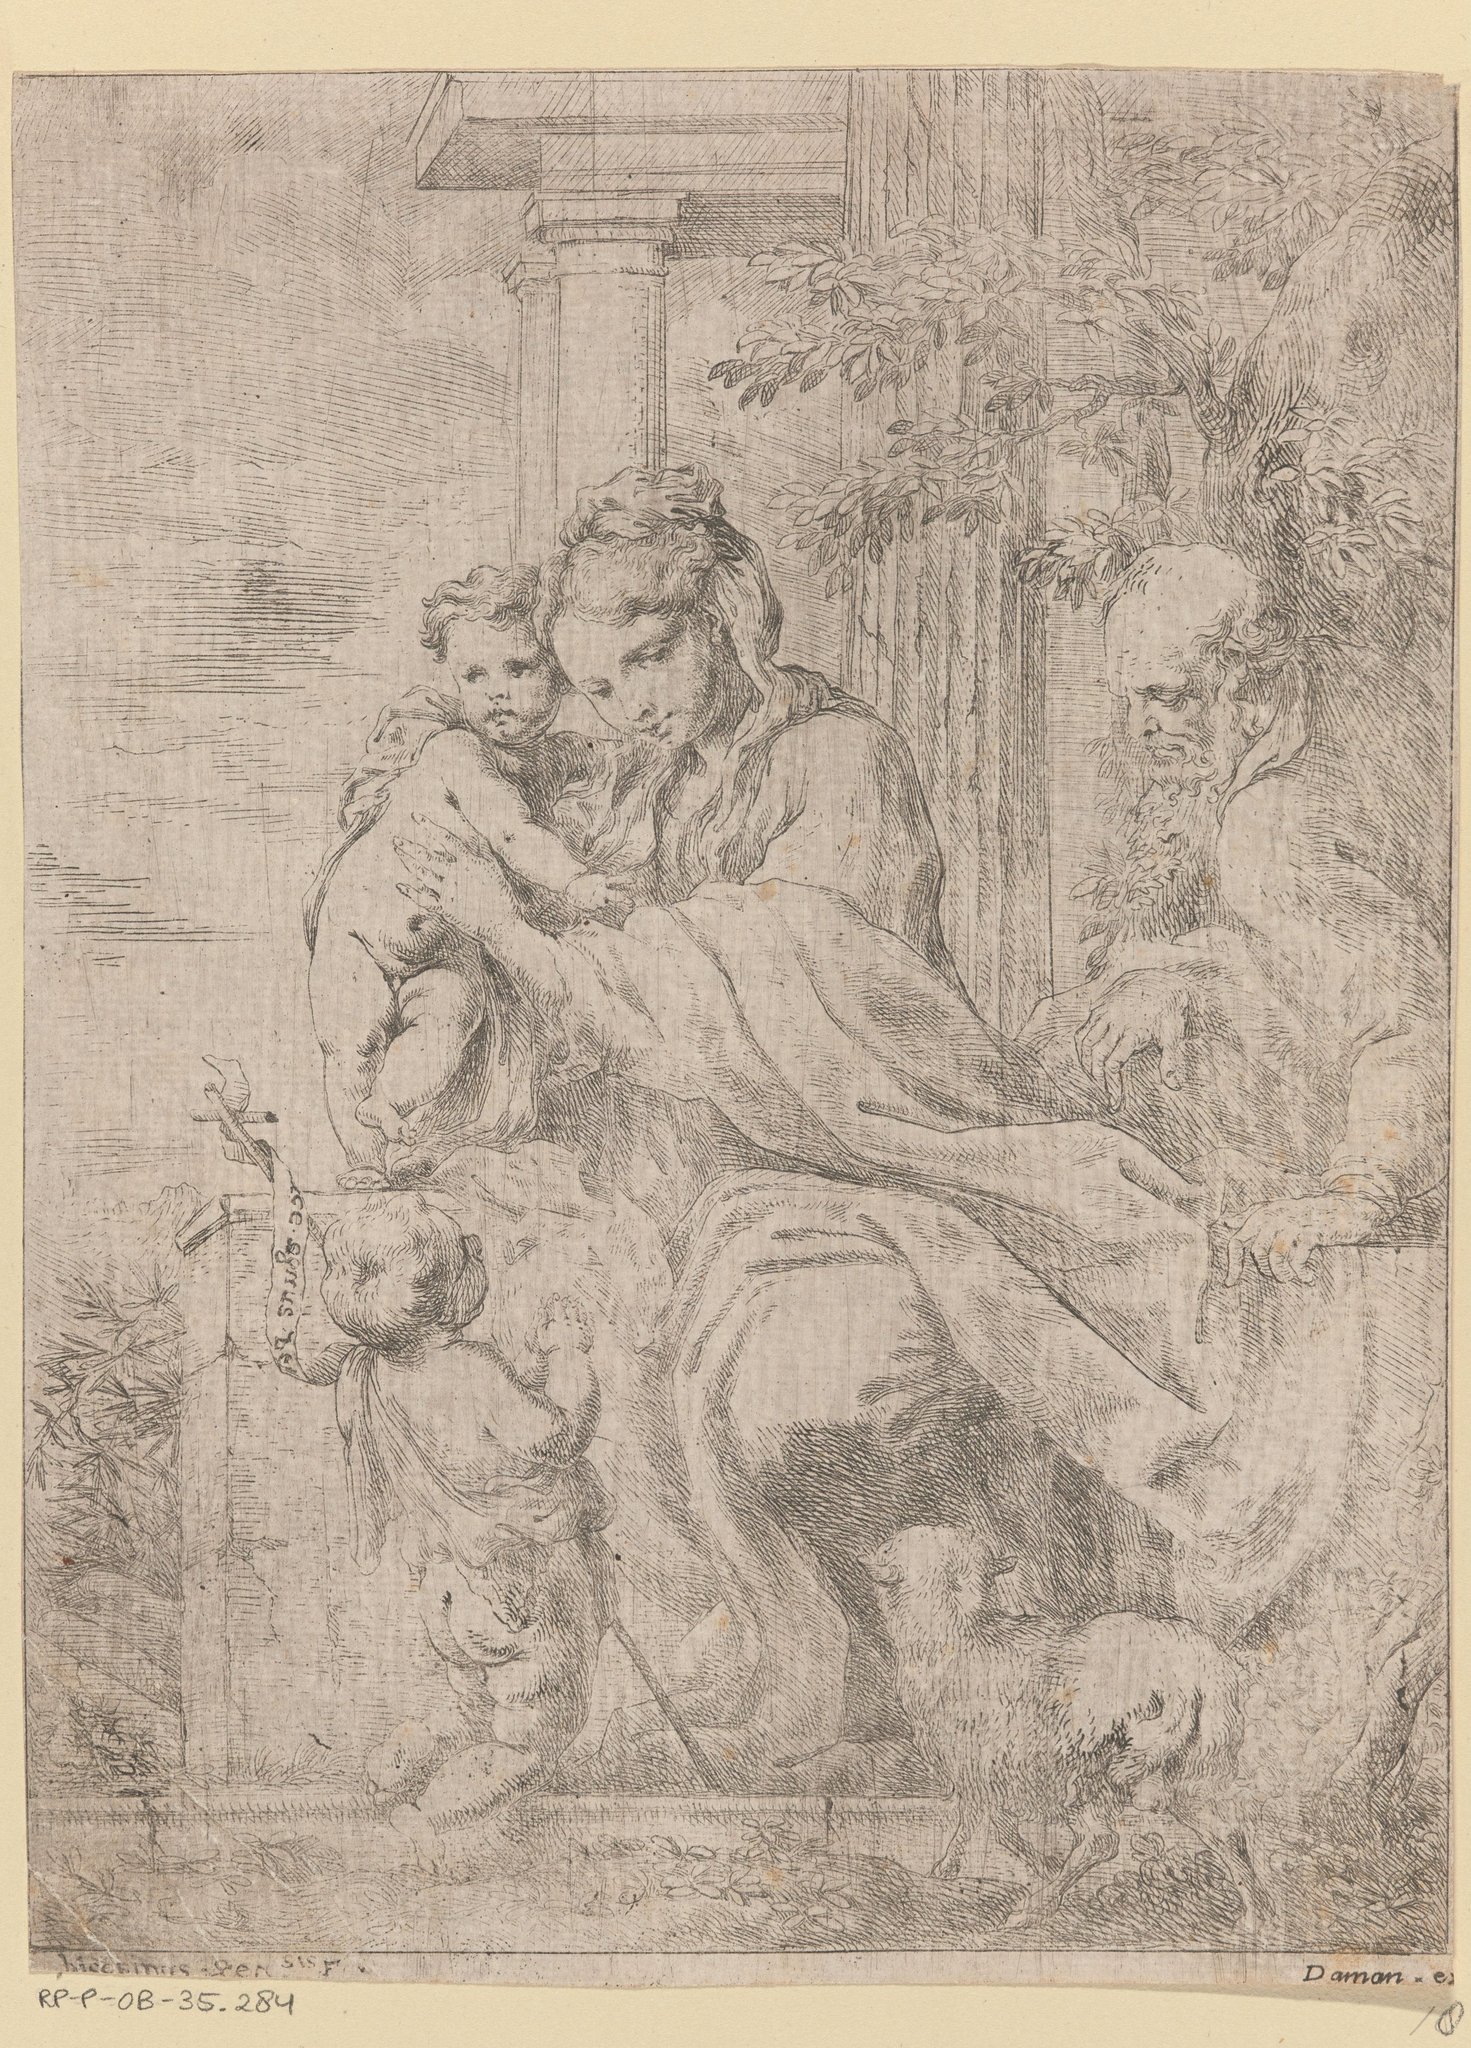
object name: print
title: Heilige Familie met de jonge Johannes de Doper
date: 1642-1657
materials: paper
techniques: etching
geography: italy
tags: holy family, and derived representations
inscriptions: collector's mark: Lugt 240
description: Maria, Jozef en het Christuskind samen met de jonge Johannes de Doper en zijn lam voor een tempel.